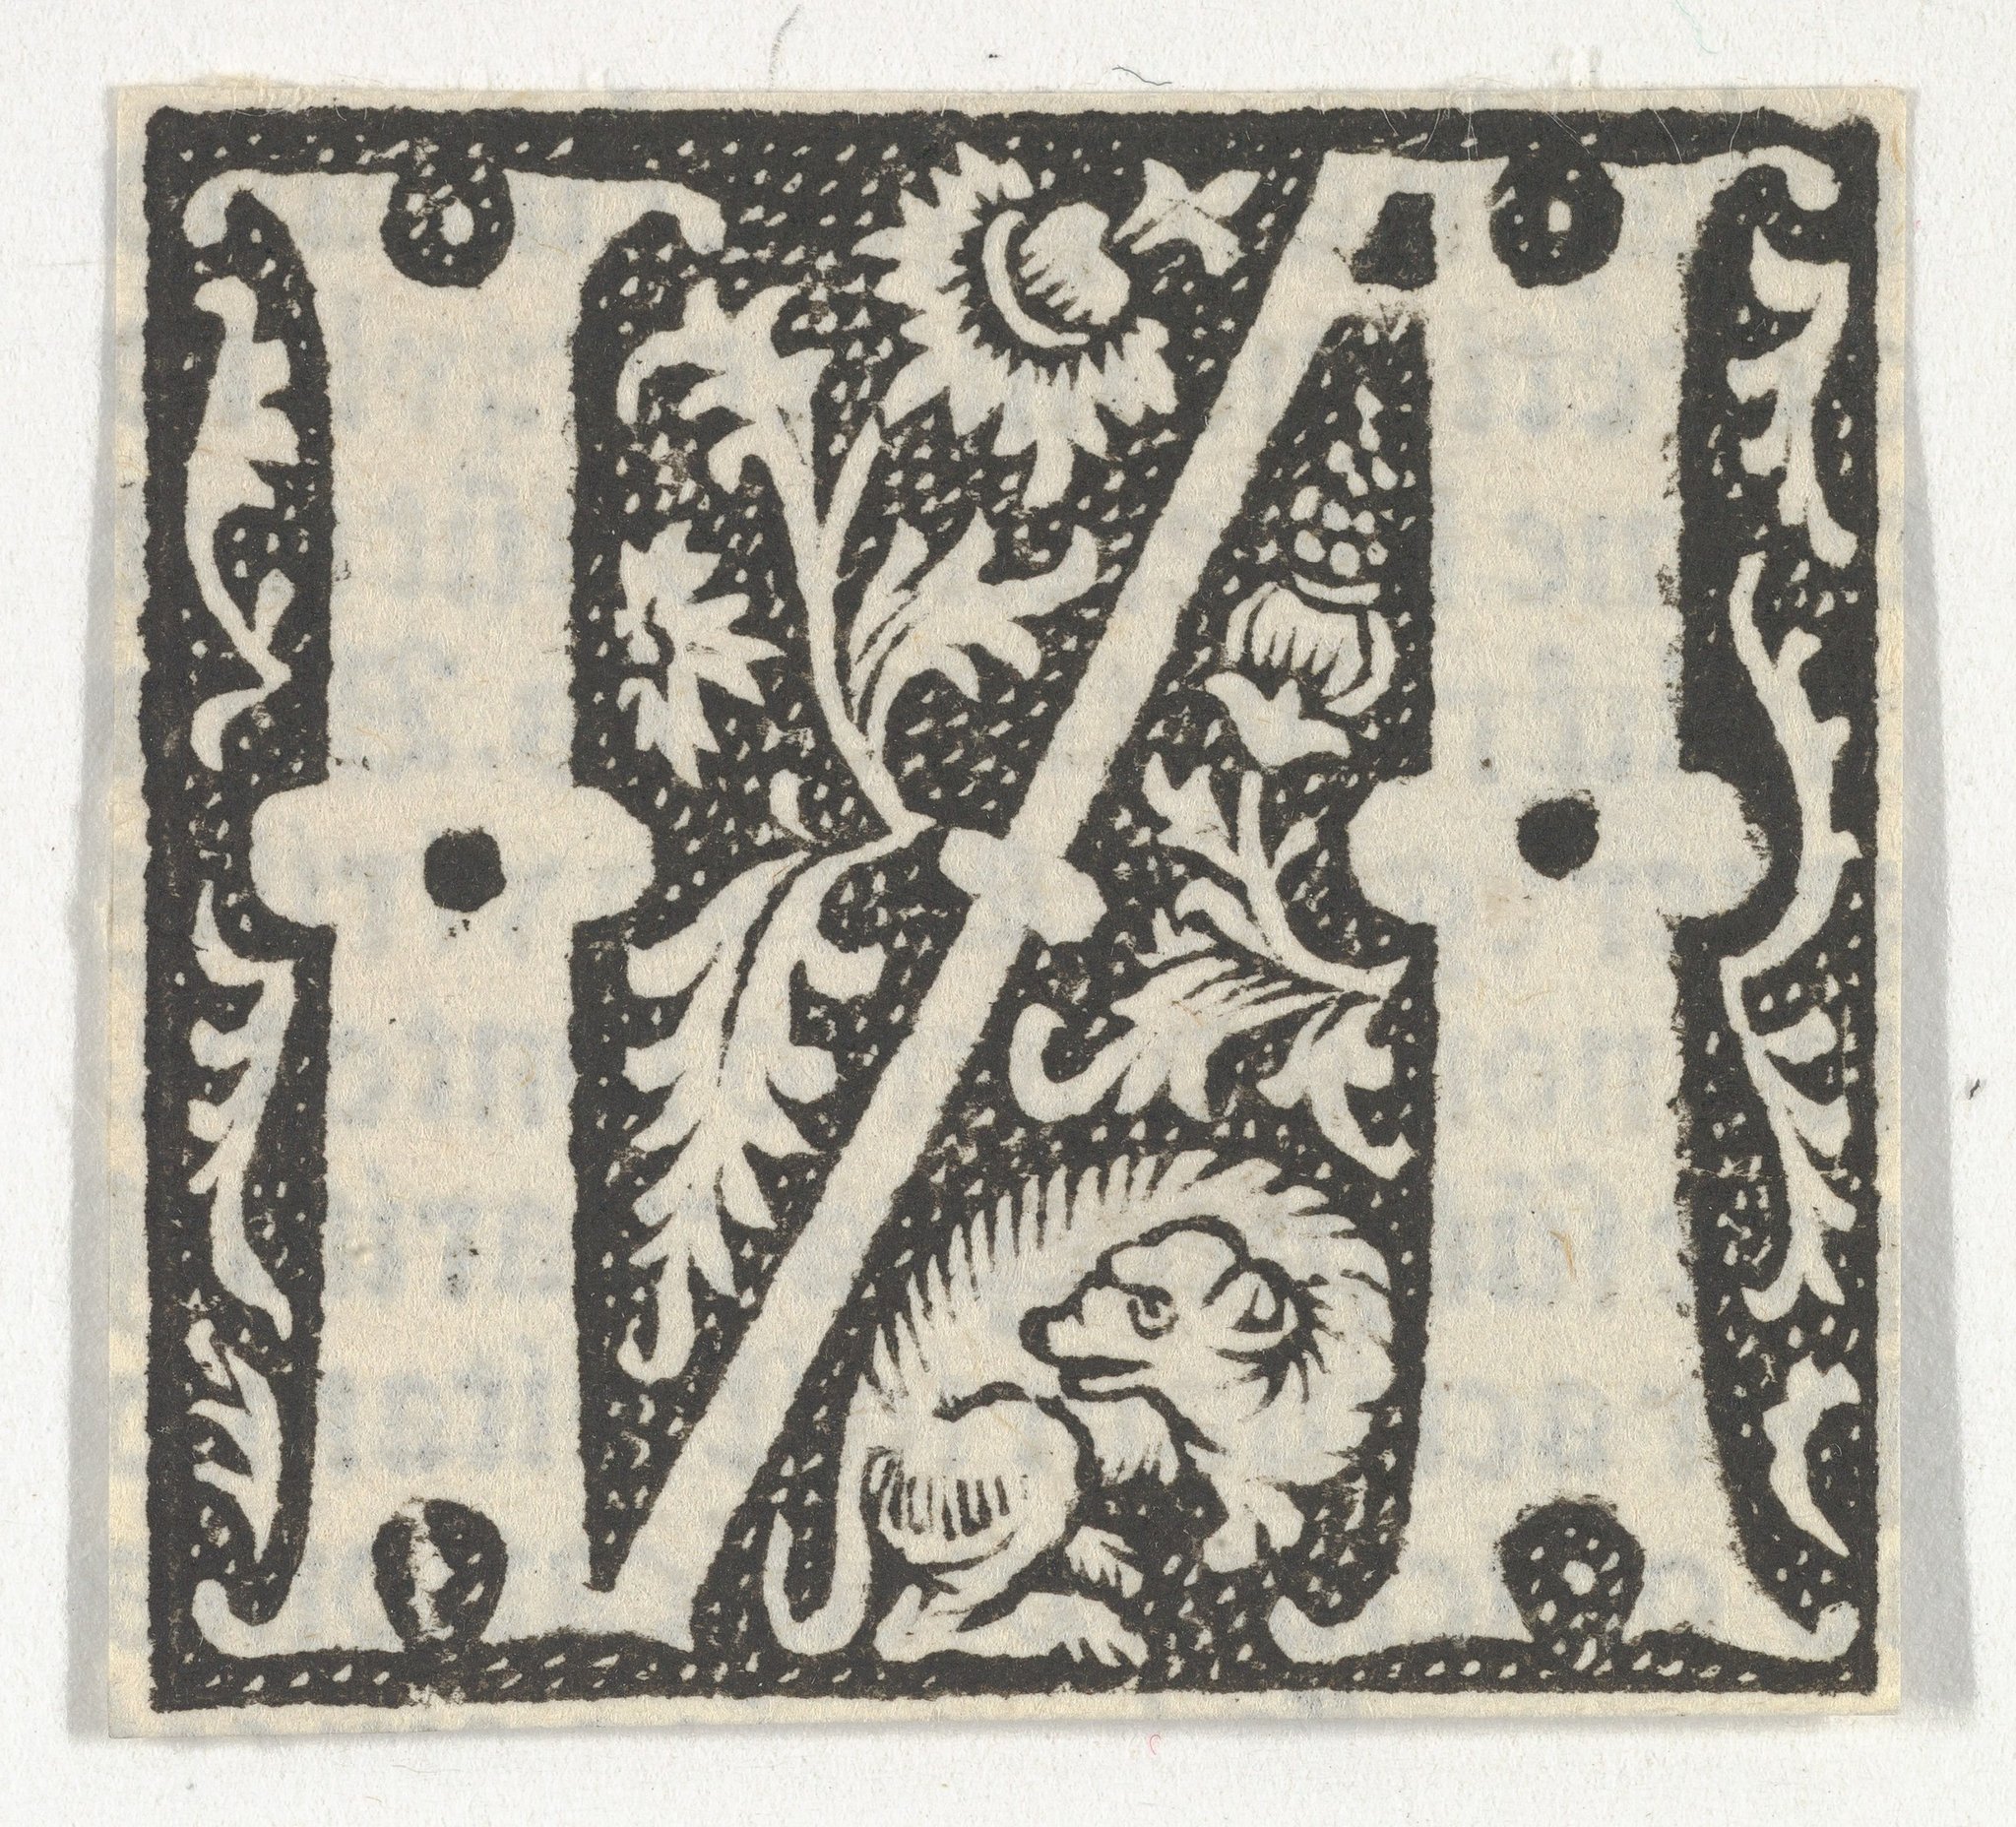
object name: print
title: Decorated Roman alphabet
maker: anonymous, french, 15th century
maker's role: artist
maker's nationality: french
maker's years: 1400-1500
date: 1499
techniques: woodcut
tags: animals,flowers